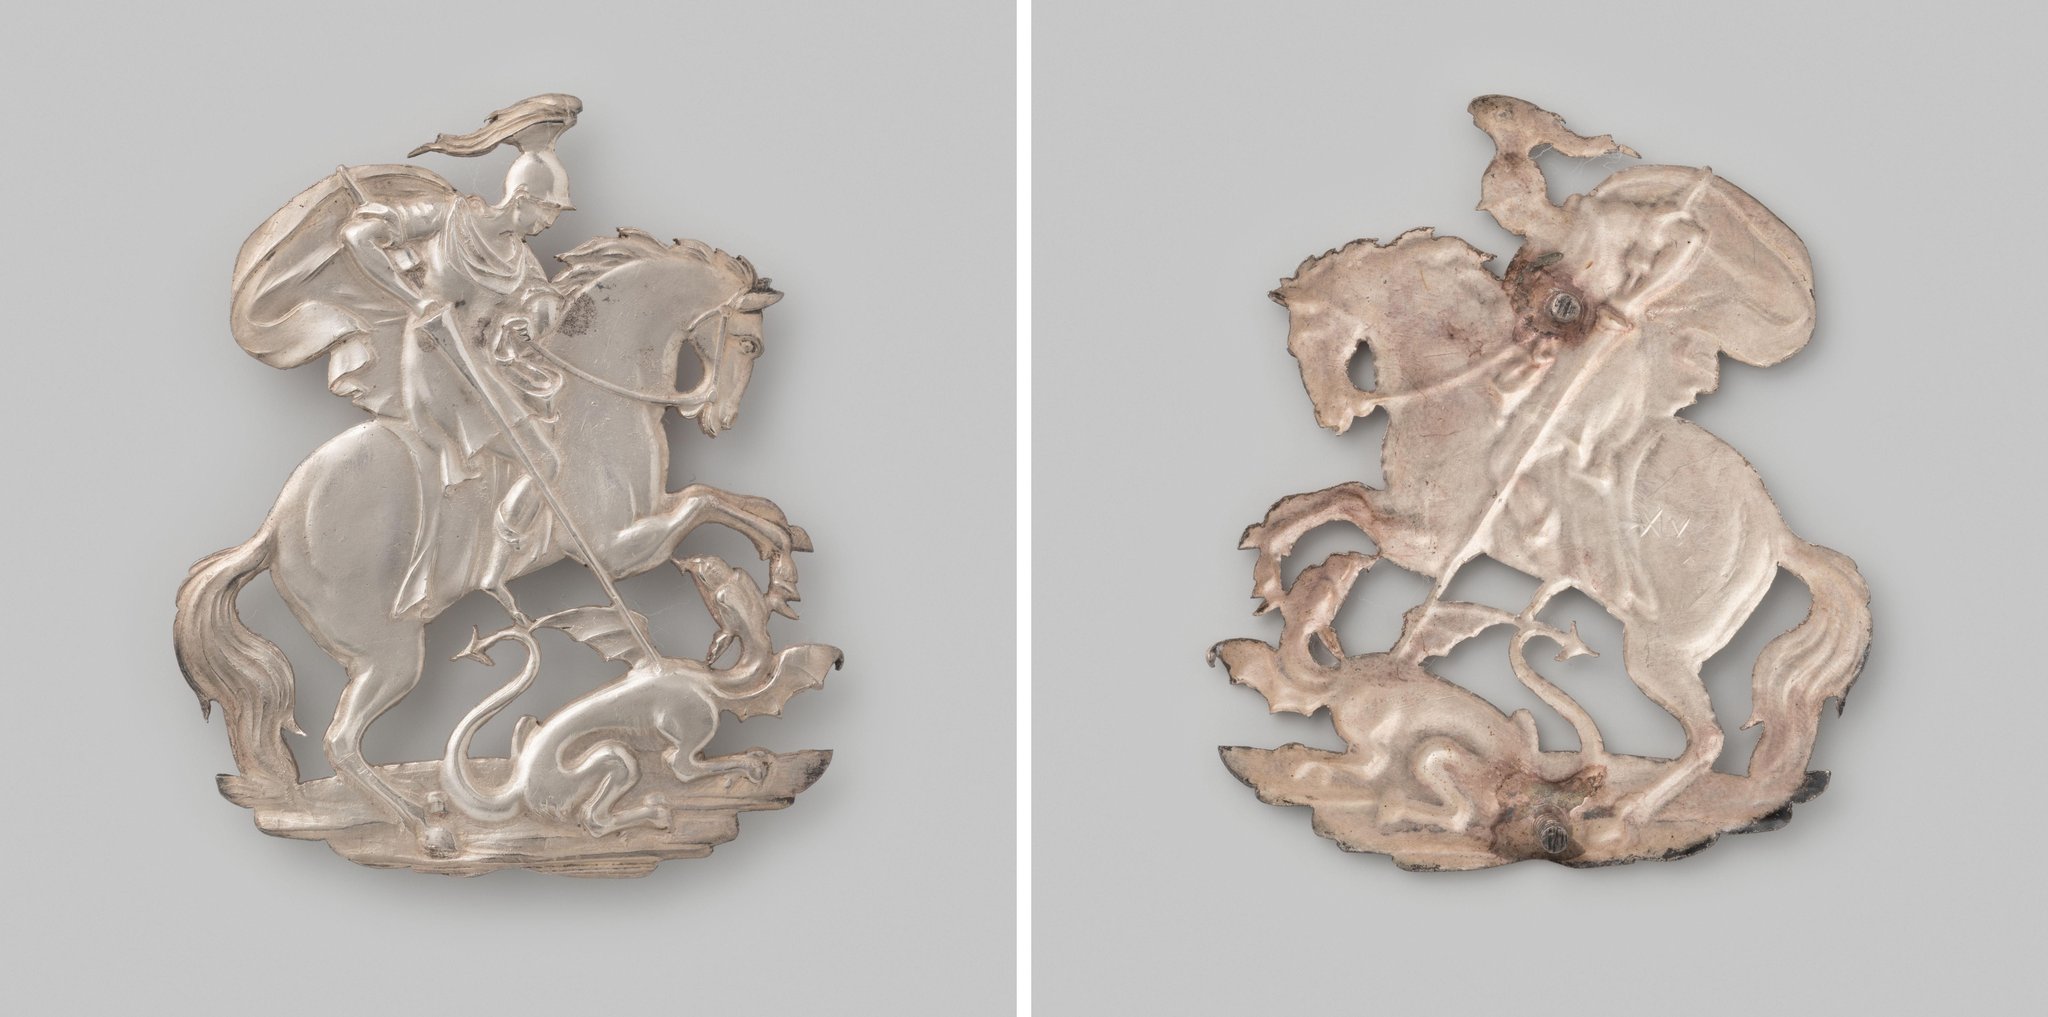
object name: plaque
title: Schutterij van St. Joris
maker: Anonymous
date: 1750-1850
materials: silver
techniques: casting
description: Eenzijdige plaquette; aan keerzijde twee schroefdraden. Voorzijde: gehelmde St. Joris te paard doorsteekt met lans ter aarde liggende draak. Keerzijde: blanco.